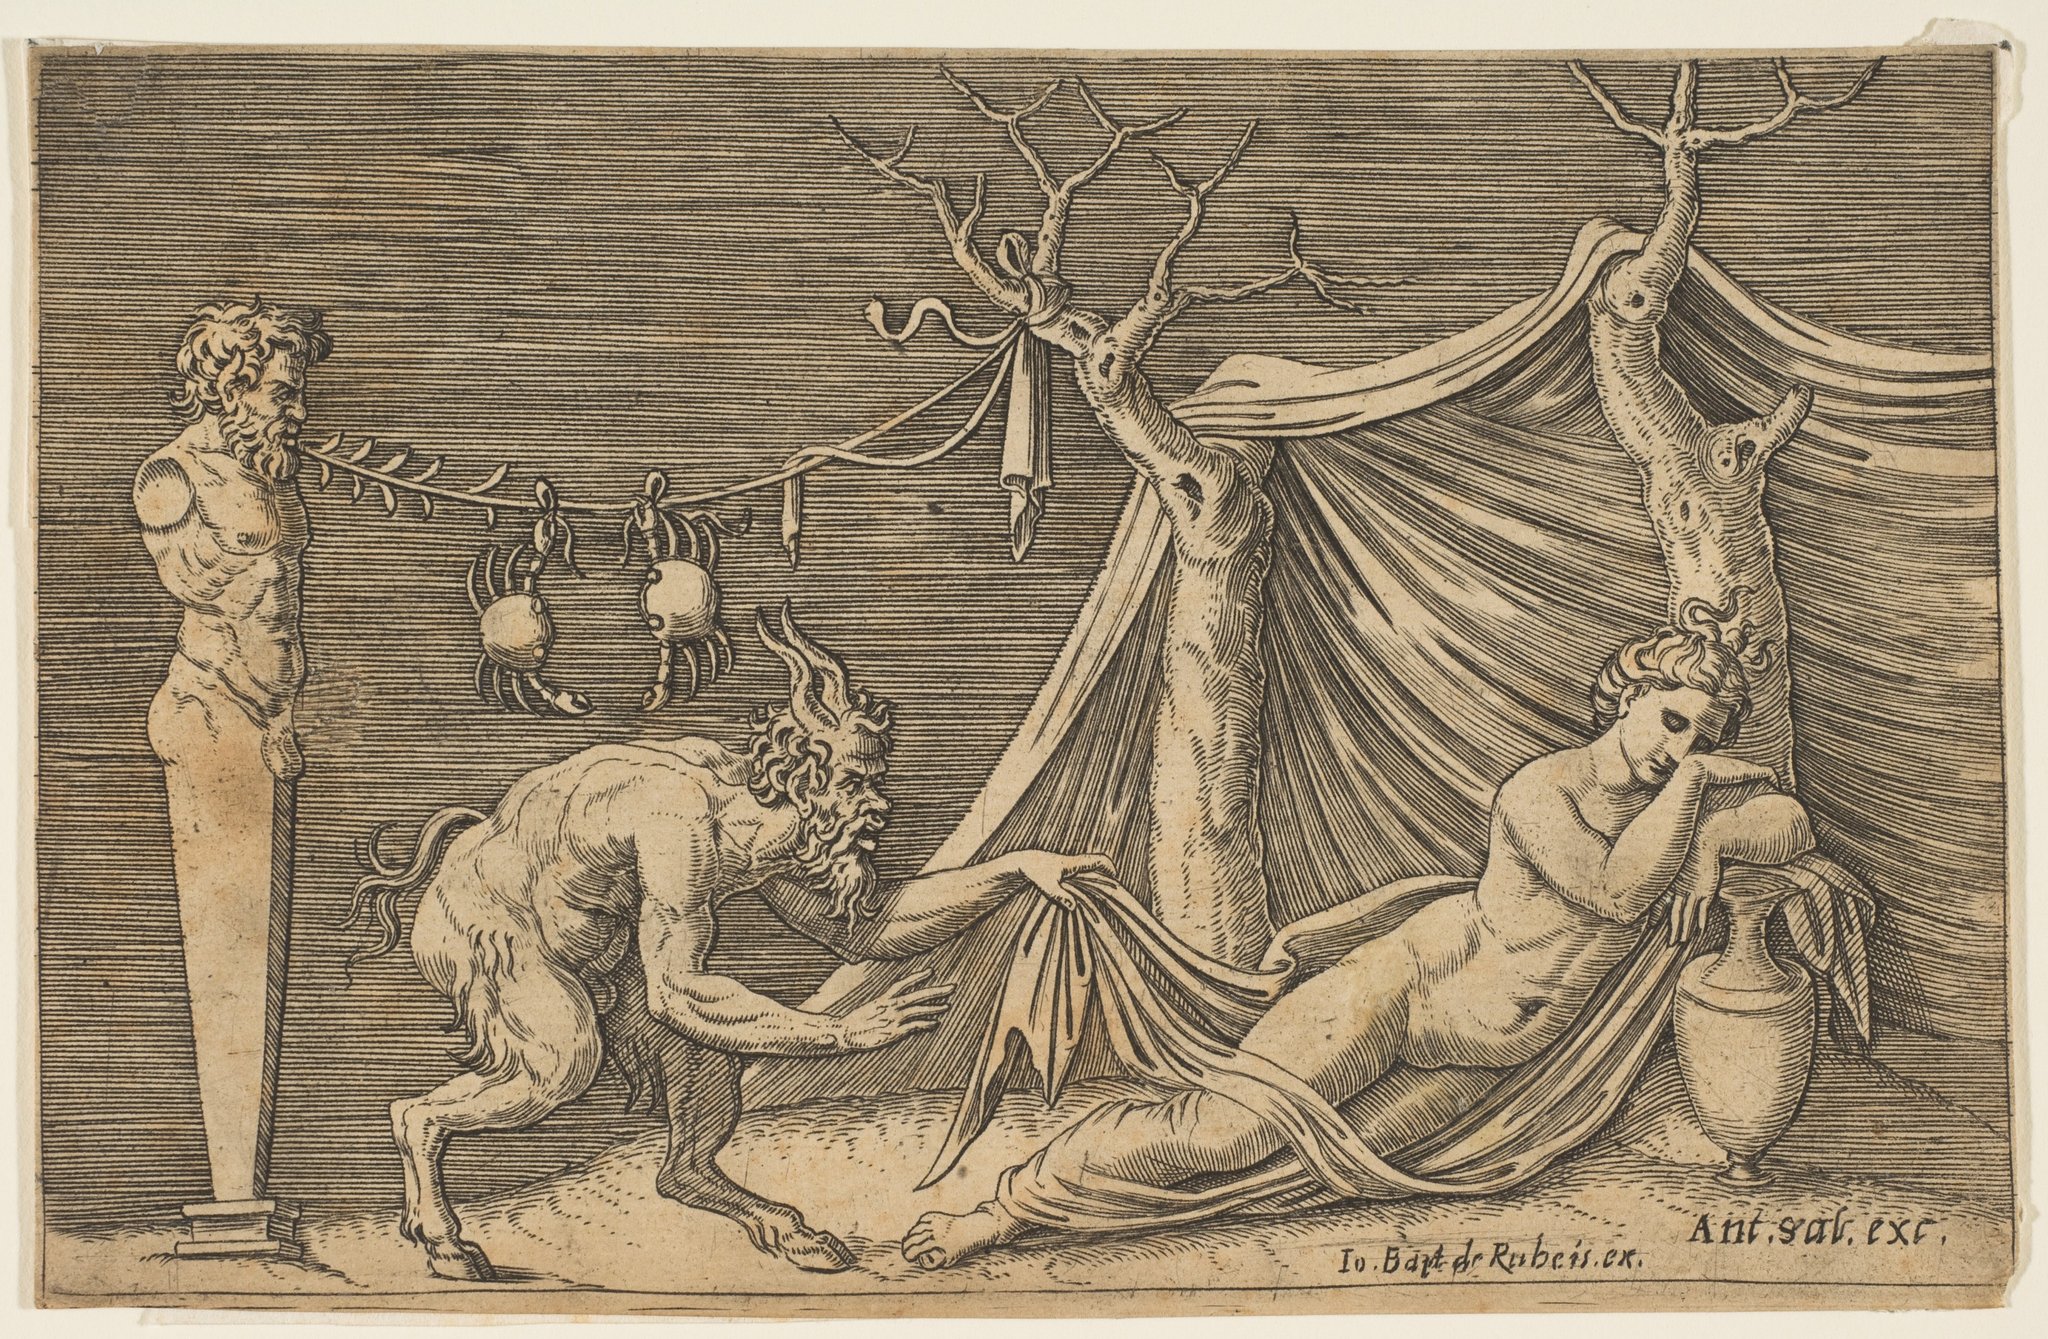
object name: print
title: A satyr discovering a sleeping woman; two crabs hanging from a rope which is strung between a term and a tree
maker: marco dente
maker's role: artist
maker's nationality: italian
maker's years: 1515-1527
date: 1515-1527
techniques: engraving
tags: sleeping,female nudes,satyrs,crabs,trees